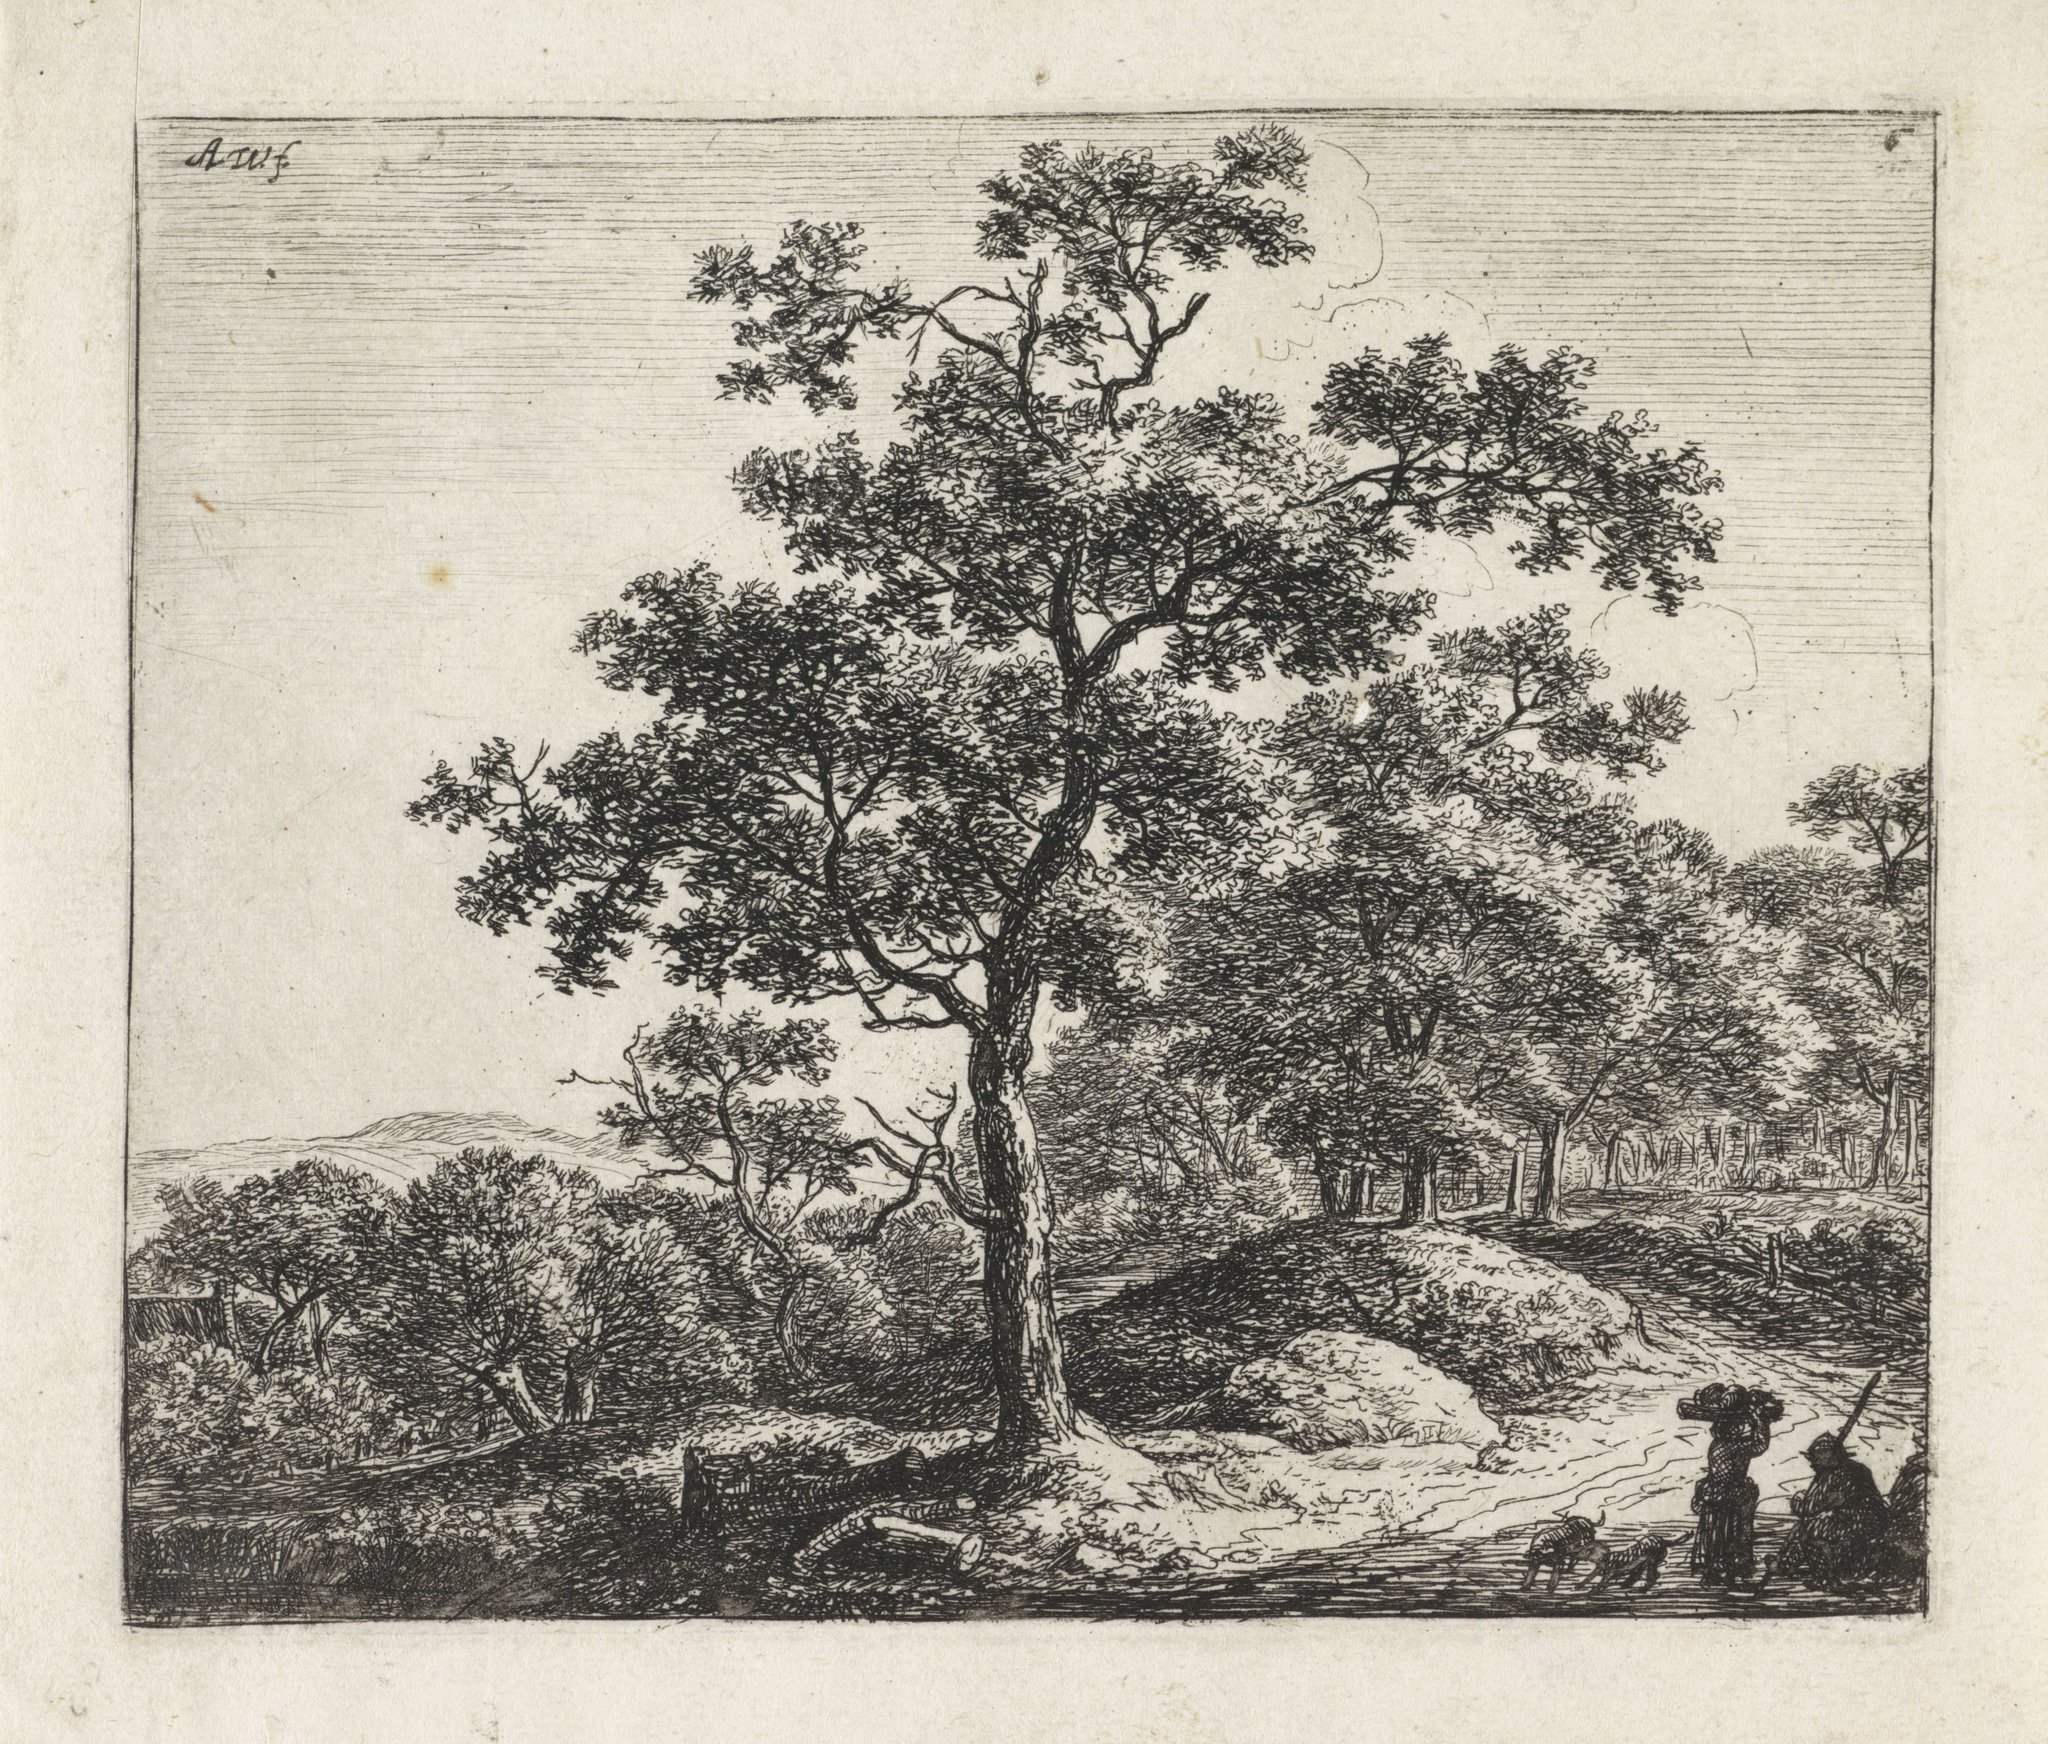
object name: print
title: Landschappen met boompartijen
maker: anthonie waterloo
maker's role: draughtsman, painter, print maker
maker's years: 1609-1690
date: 1630-1663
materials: paper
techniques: etching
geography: amsterdam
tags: forest, wood, 'en route', traveller under way, landscapes (+ landscape with figures, staffage), farm or solitary house in landscape, resting - bb - out of doors, dog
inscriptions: collector's mark: Lugt 240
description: Langs een bospad in een heuvelachtig landschap zit een man op de grond. Voor hem staat een vrouw met goederen op haar hoofd. Achter haar spelen twee honden. Links in de verte staat een huis.